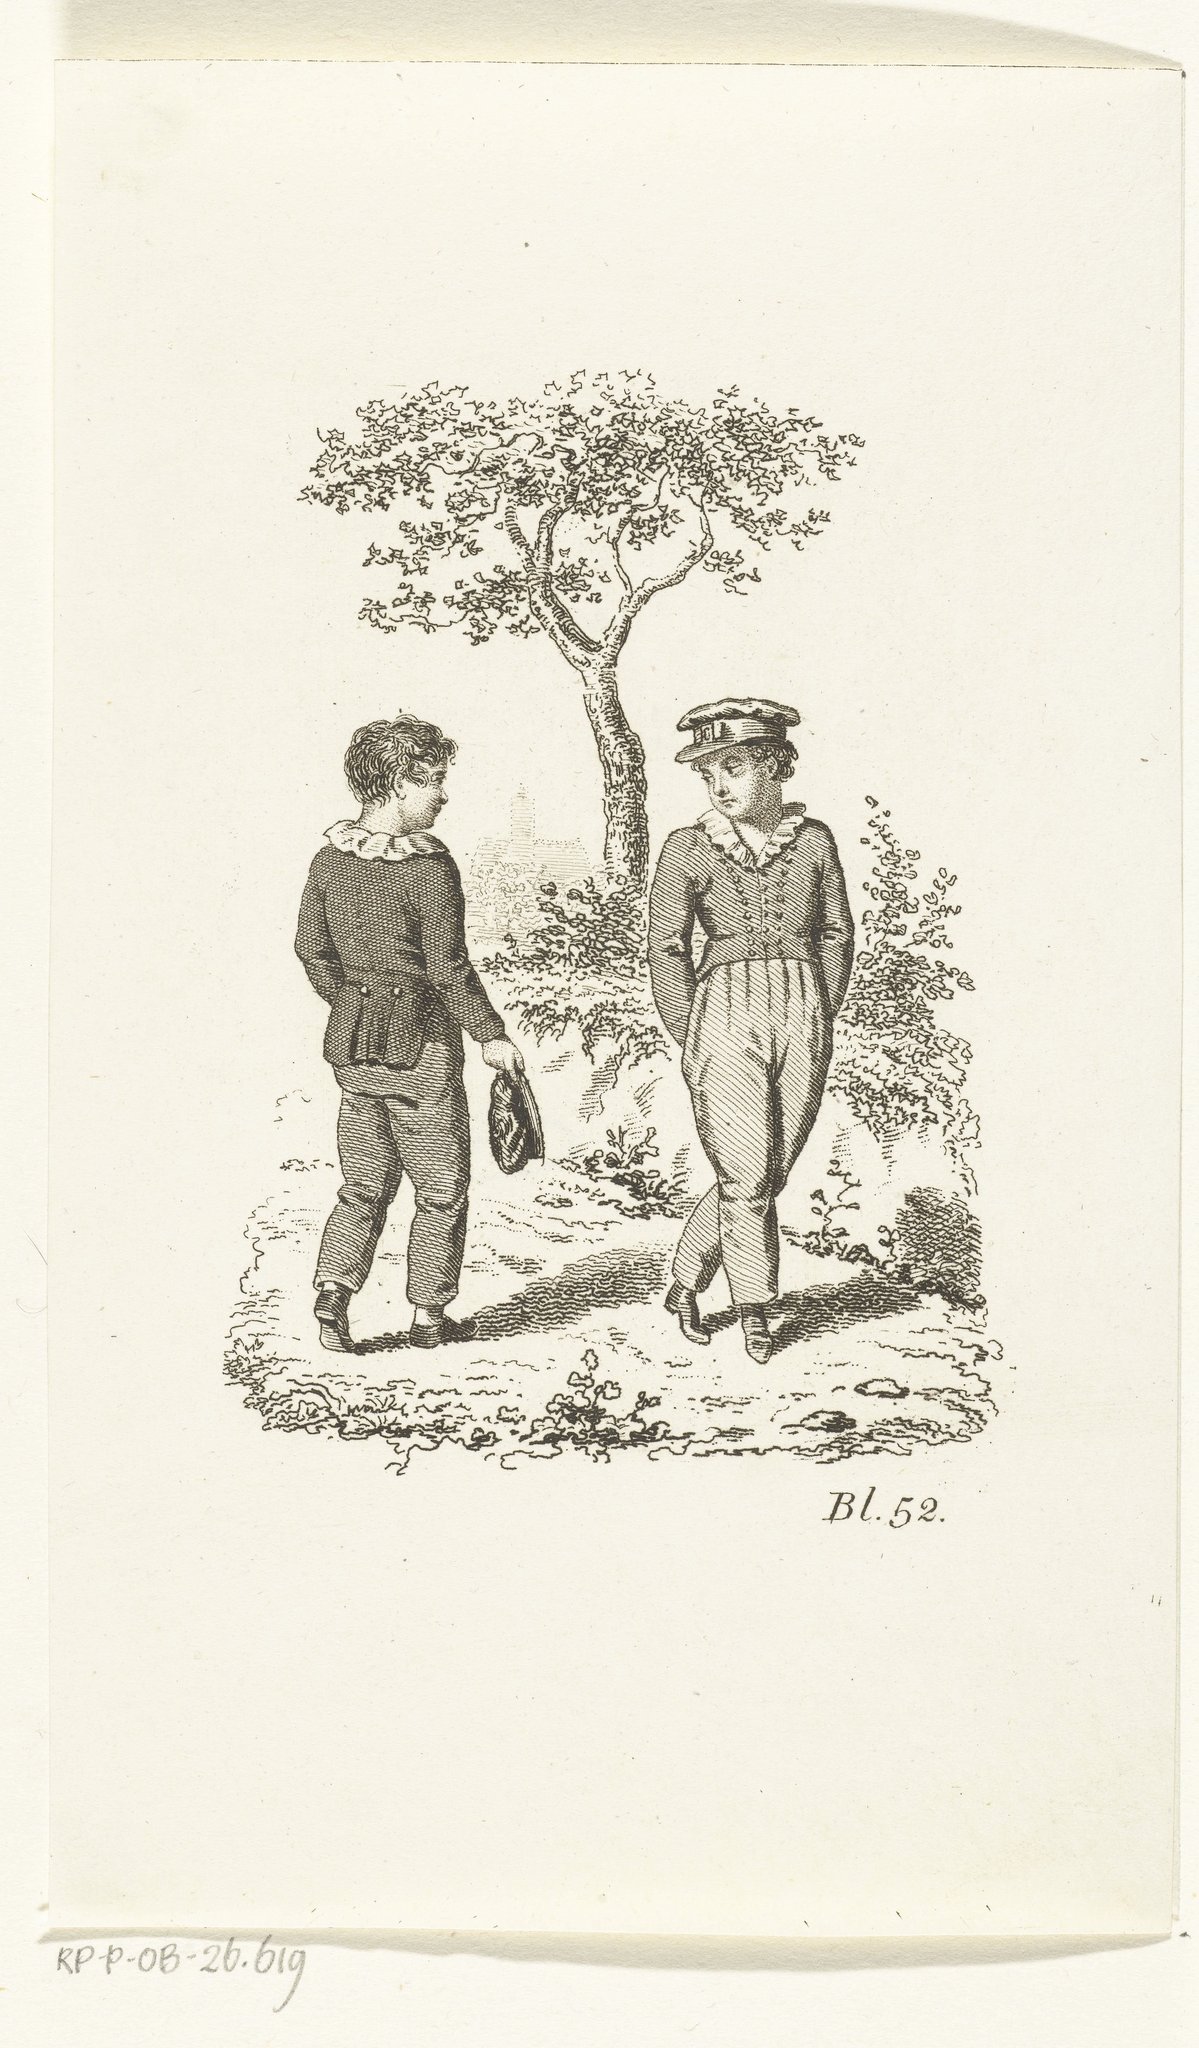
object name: book illustration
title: Twee jongens ontmoeten elkaar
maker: johannes alexander rudolf best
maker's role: print maker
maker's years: 1797-1855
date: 1807-1855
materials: paper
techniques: etching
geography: amsterdam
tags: youth, adolescent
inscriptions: collector's mark: Lugt 2228, inscription: ‘bl. 52.’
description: Prent gebruikt als boekillustratie in onbekende uitgave, illustratie bij tekst op p. 52.